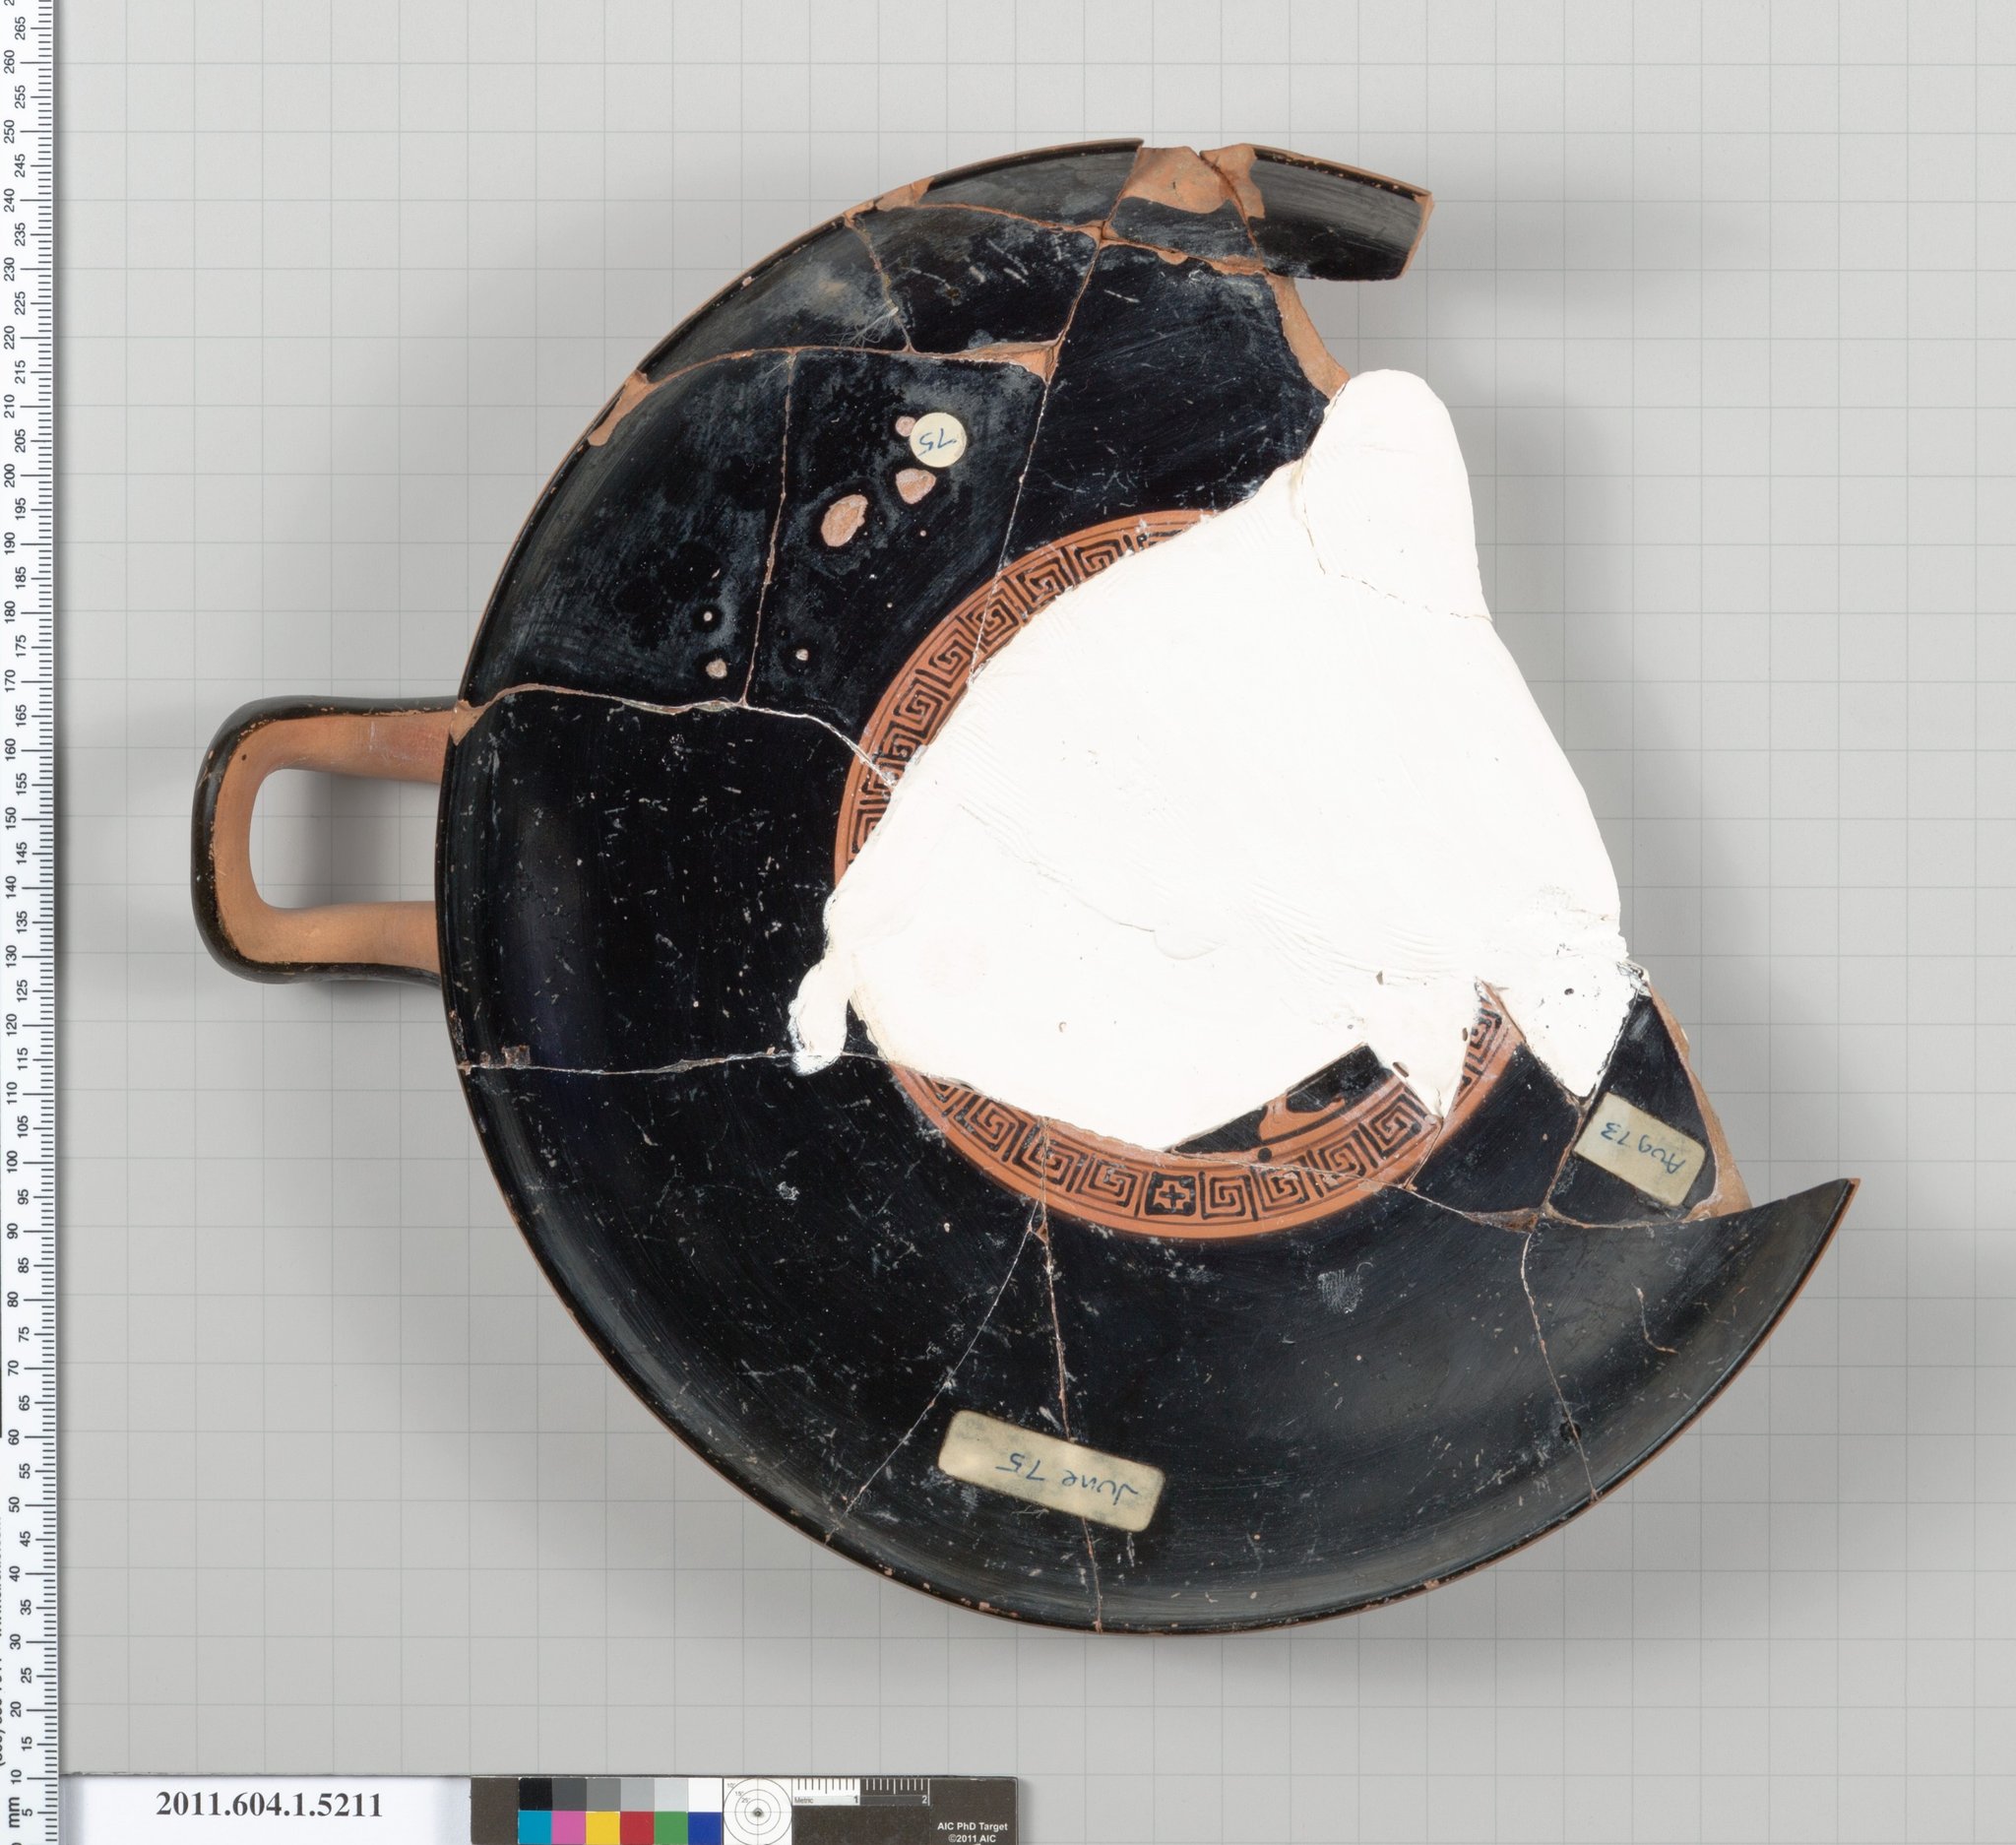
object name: kylix fragment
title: Terracotta fragment of a kylix (drinking cup)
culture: greek, attic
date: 475-451 BCE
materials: terracotta